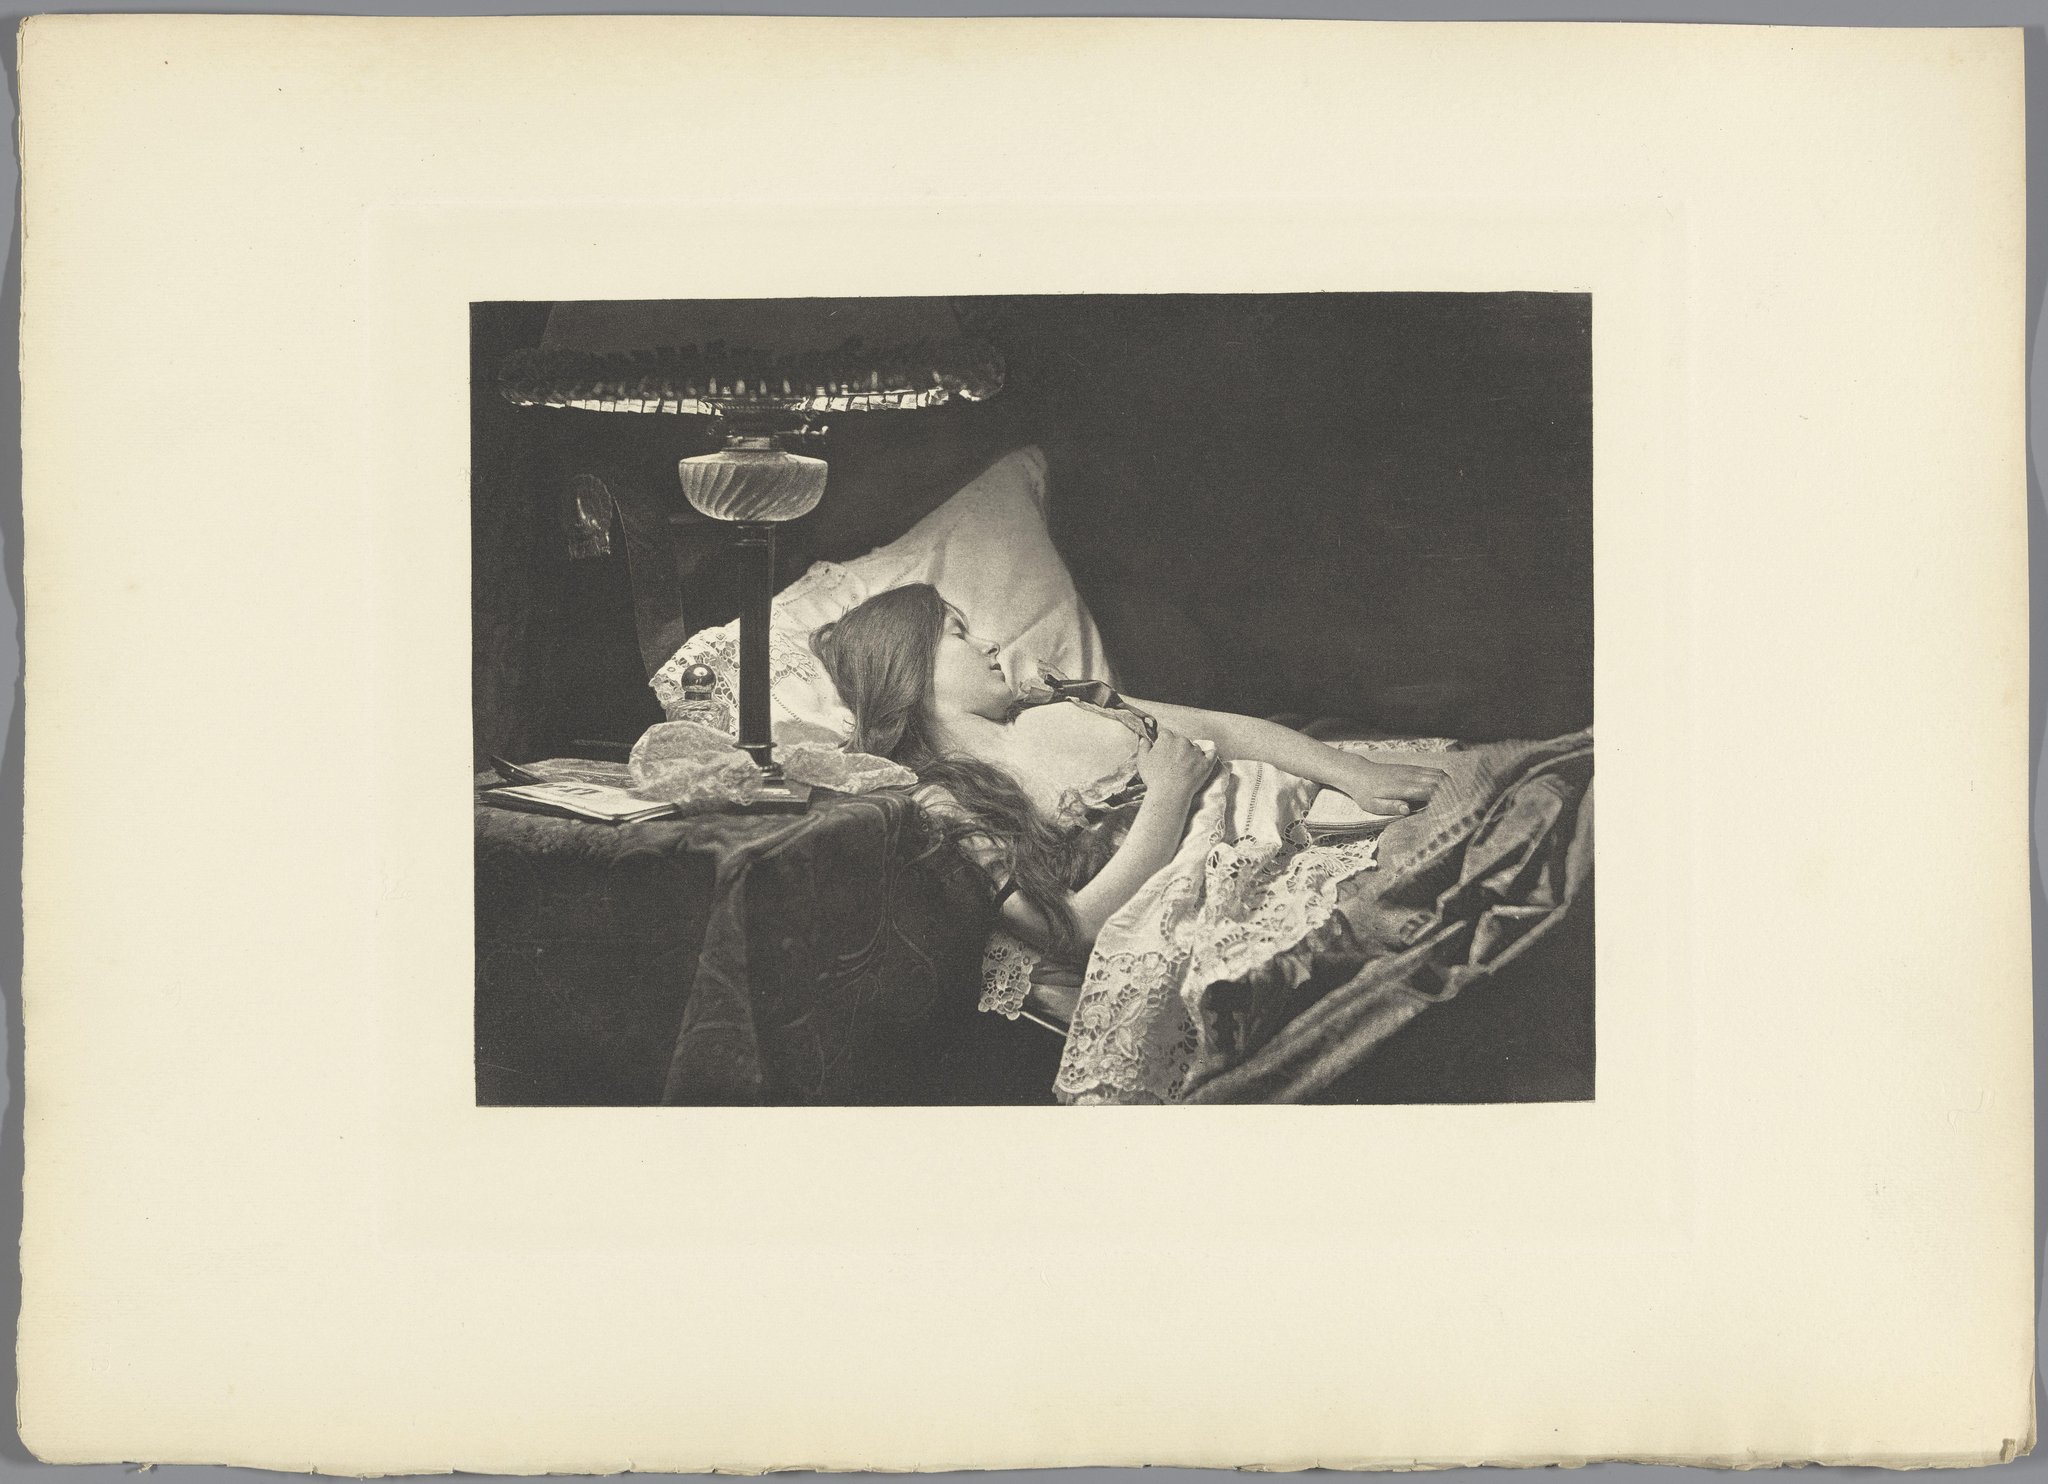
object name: photomechanical print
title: Sommeil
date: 1891-1896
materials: paper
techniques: photoaquatint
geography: paris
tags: sleeping in bed